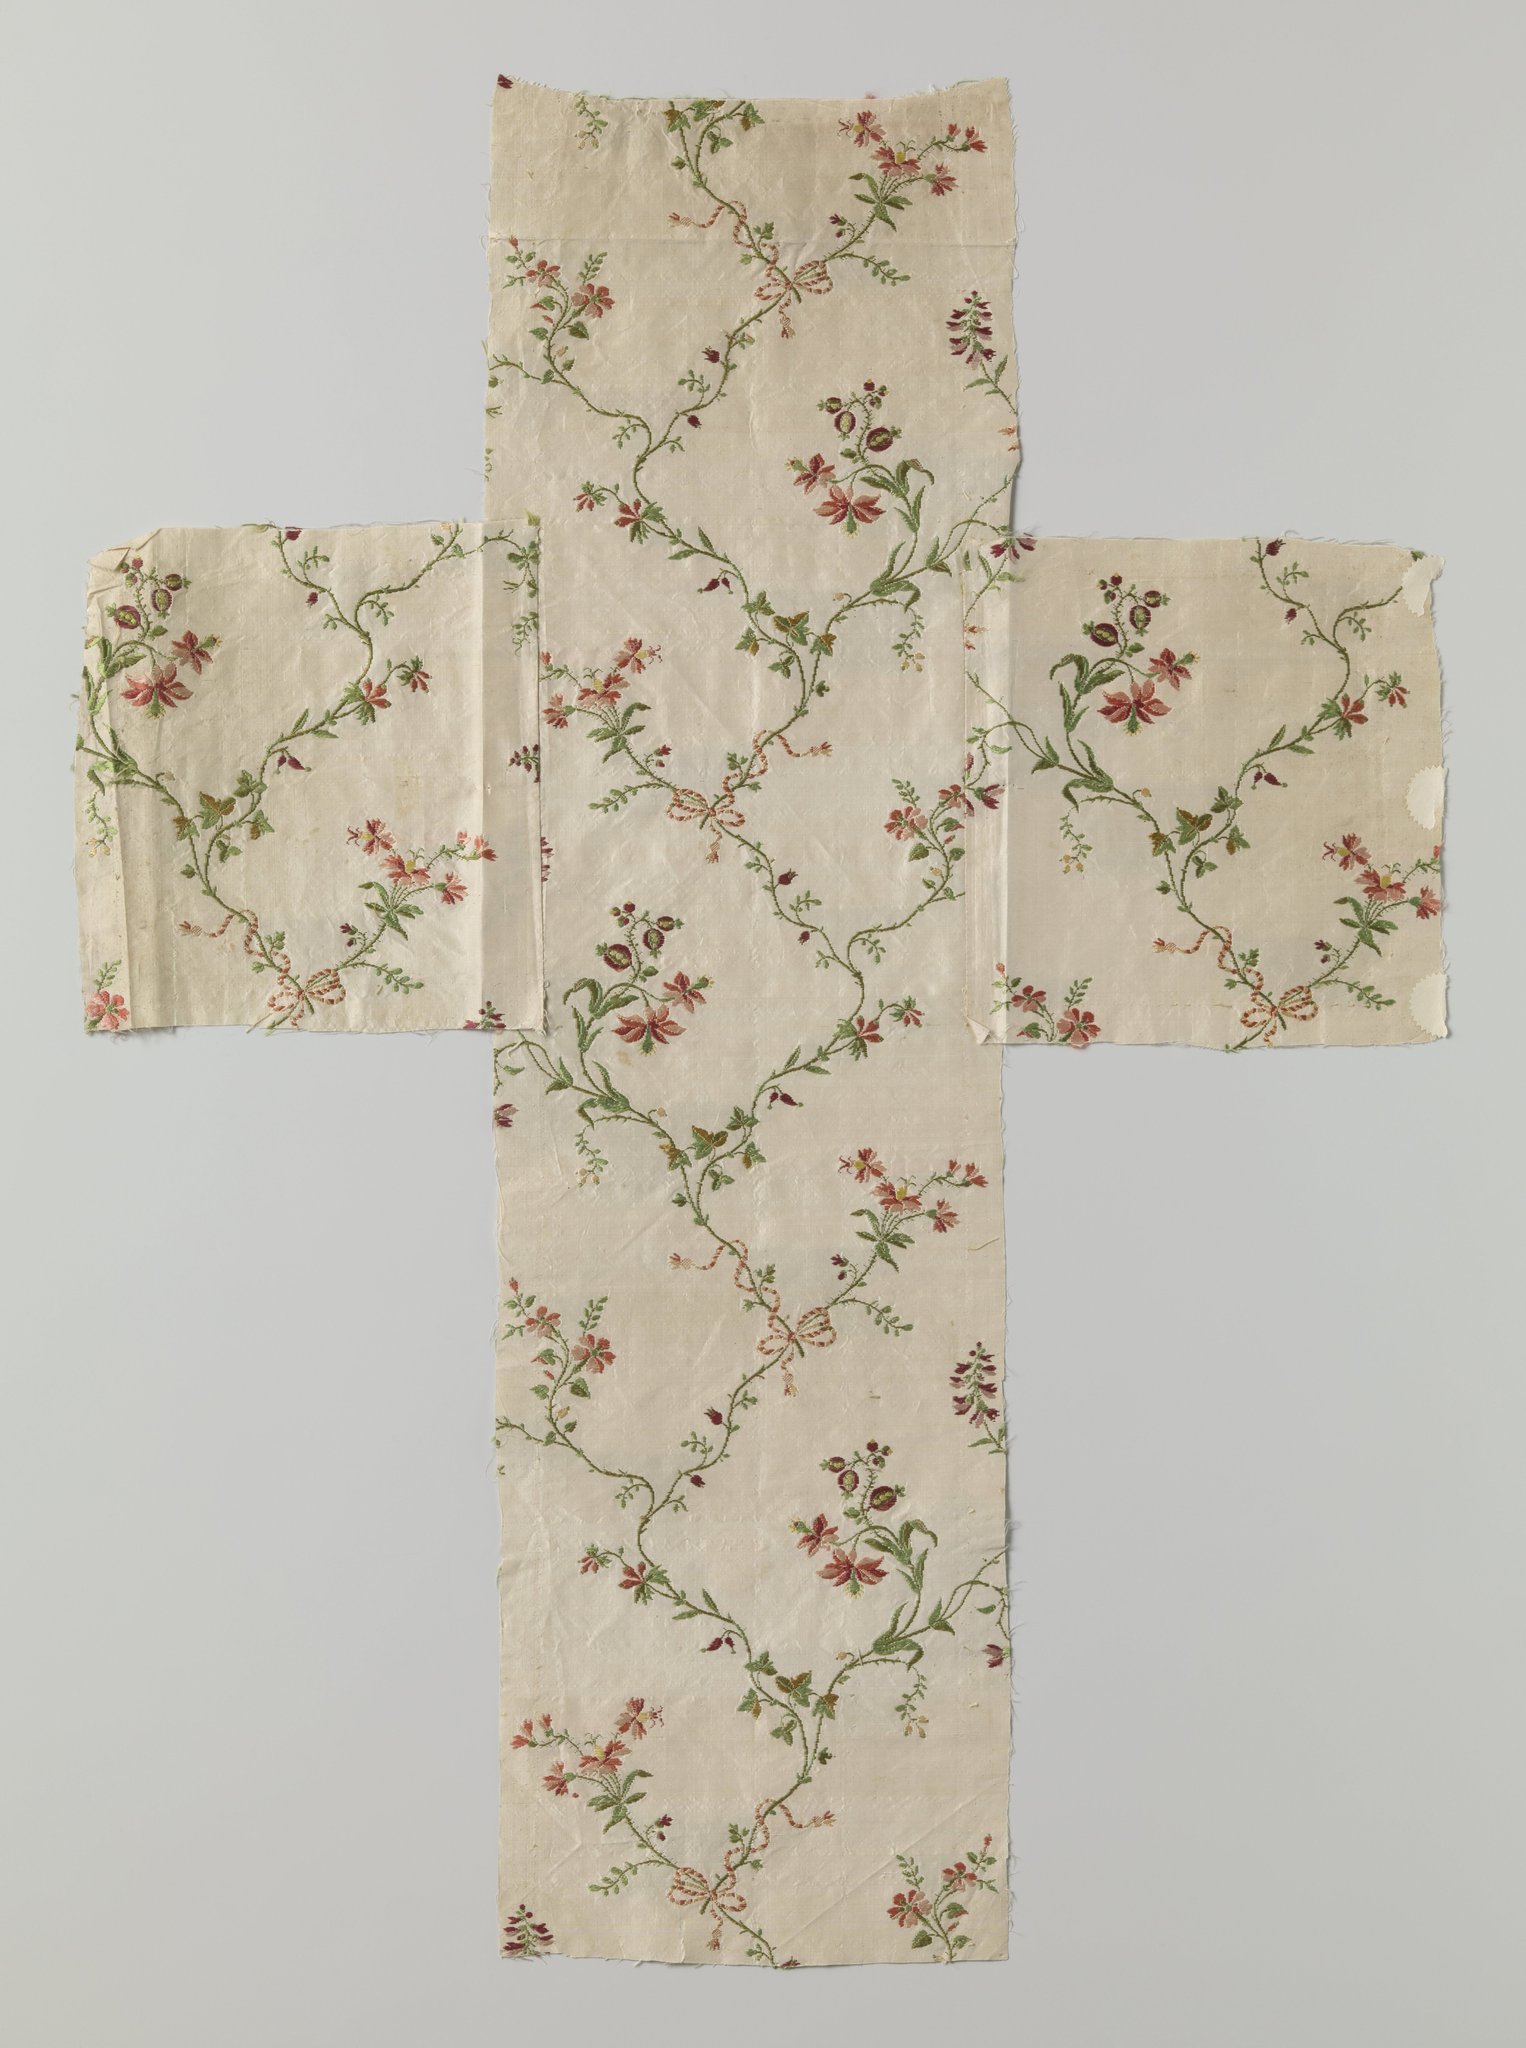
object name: fragment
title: Kruisvormig fragment gebrocheerde zijde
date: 1740-1775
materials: silk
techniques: brocade, weave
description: Fragment zijdeweefsel. Het kruisvormige fragment bestaat uit drie aaneengenaaide fragmenten. Het patroon heeft veelkleurige bloemenranken met rood/wit gestreepte strikken.